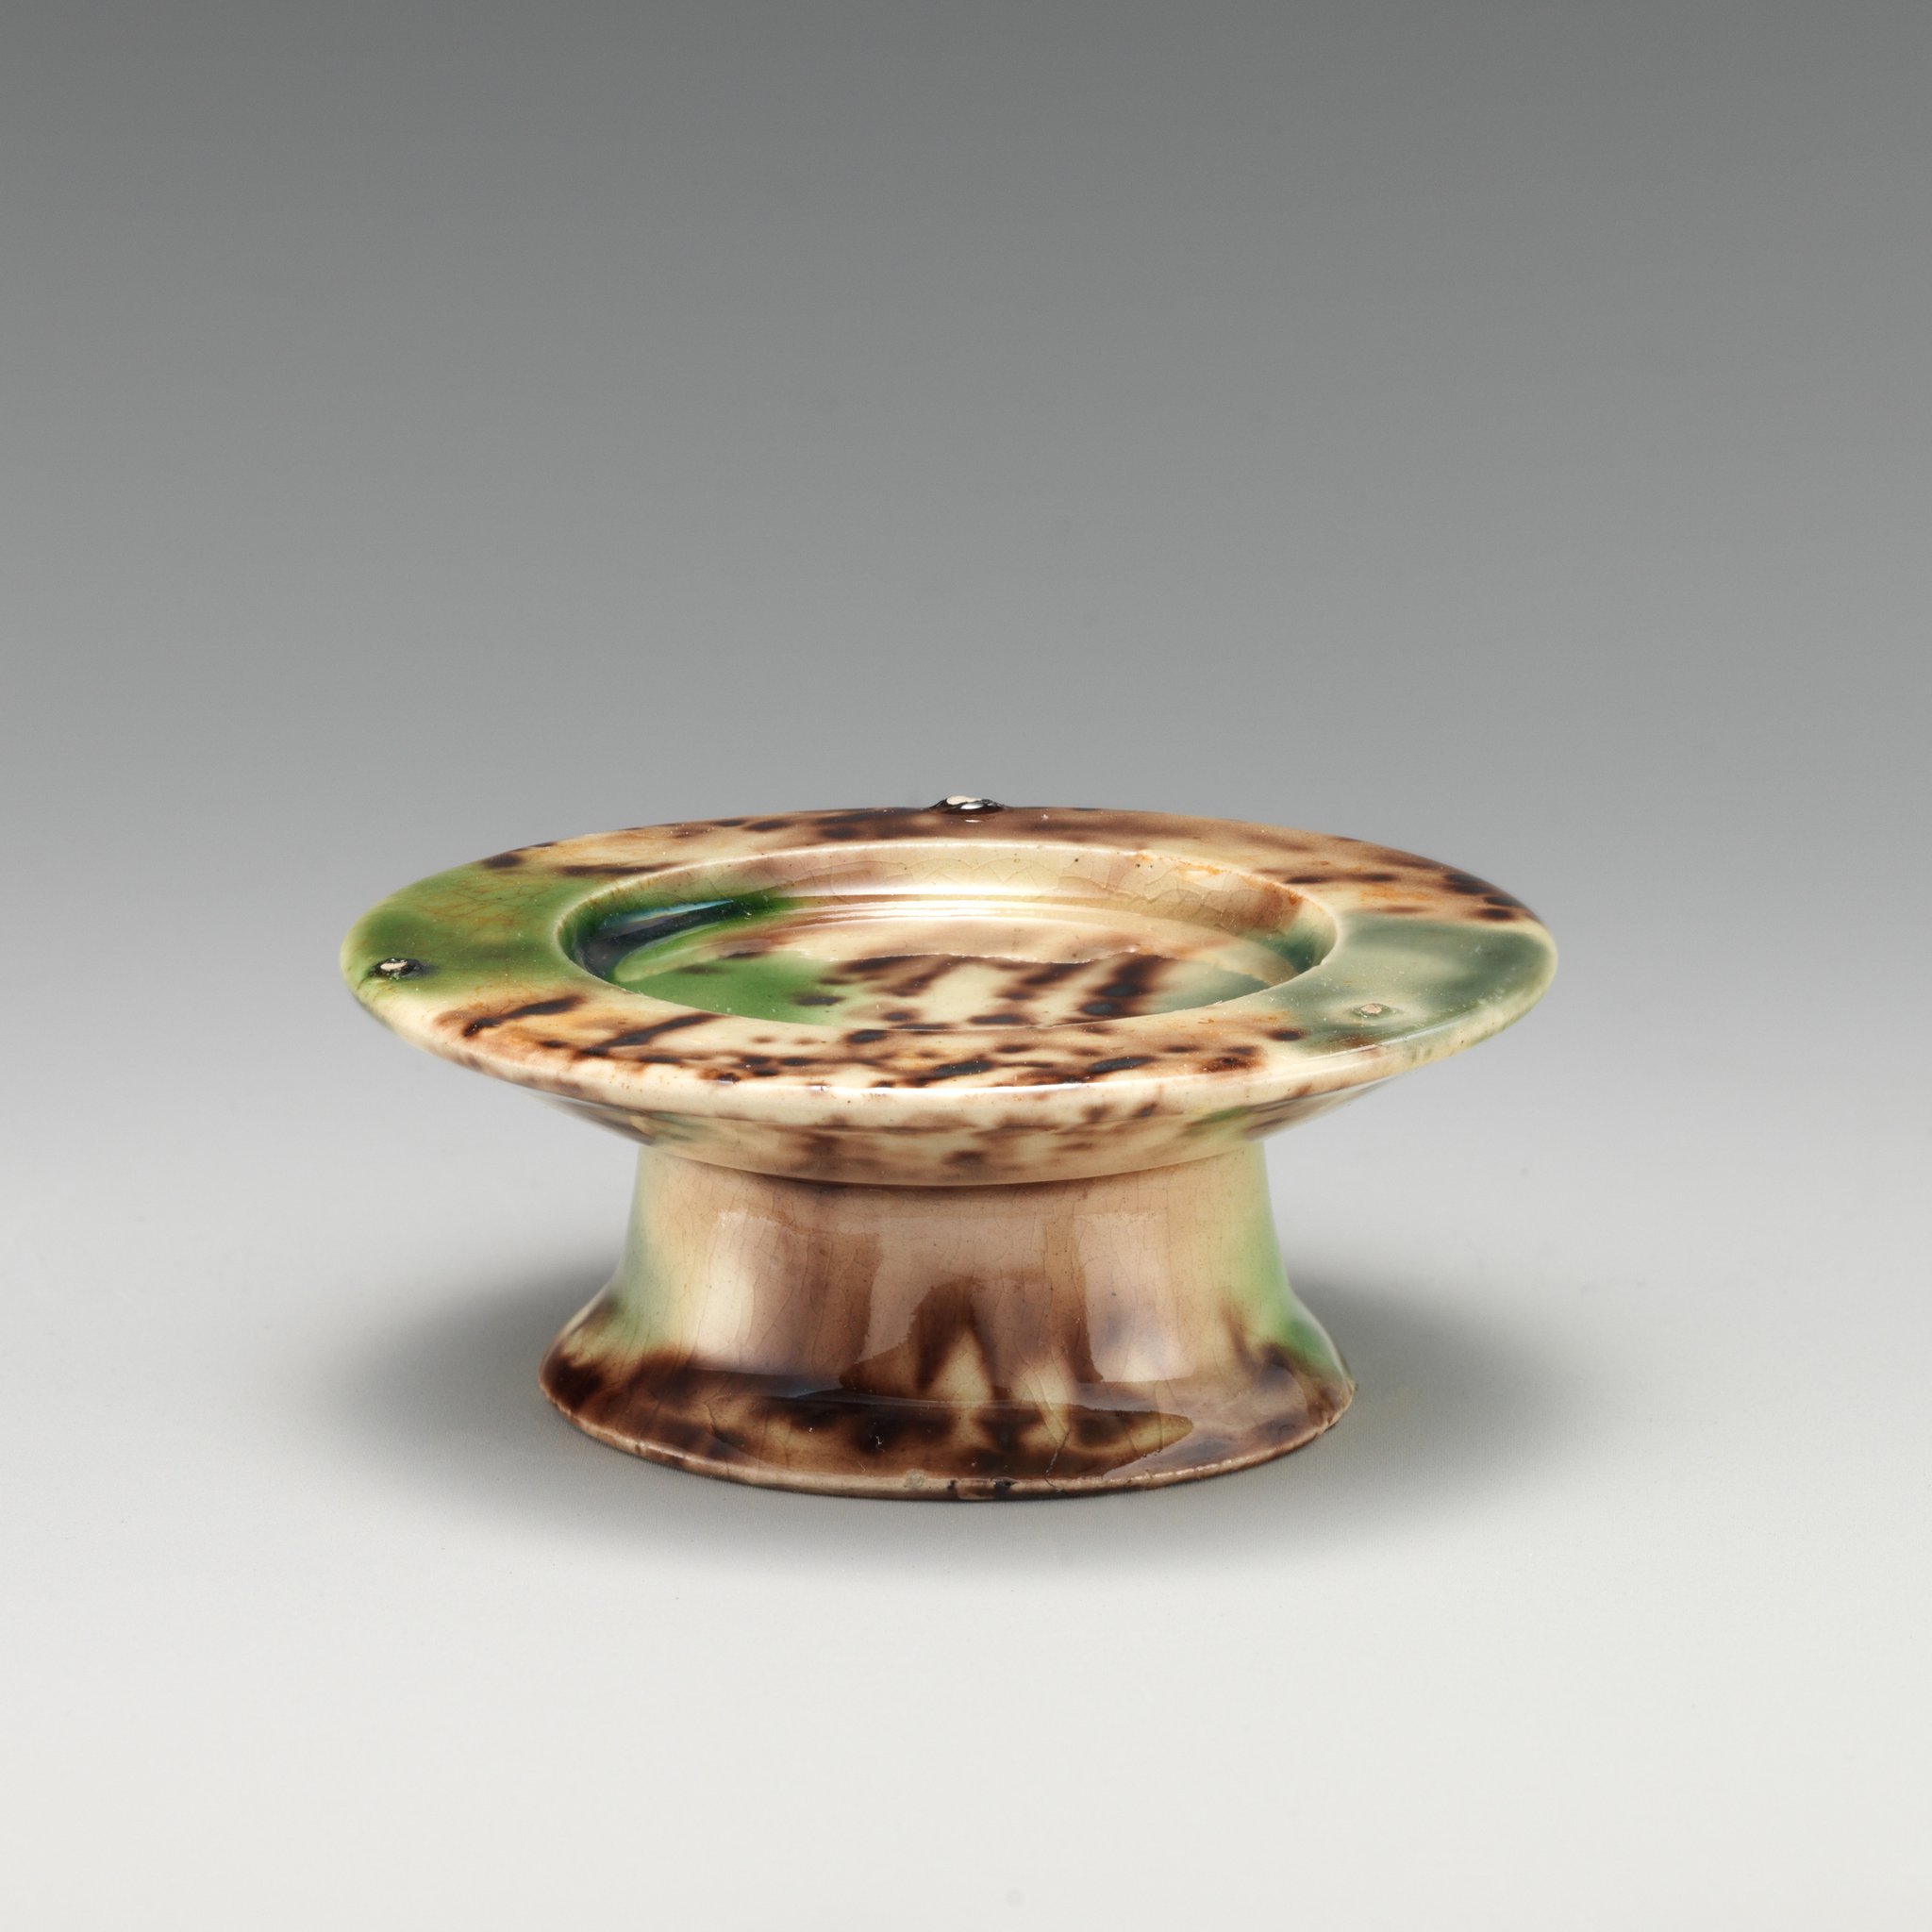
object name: tazza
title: Miniature tazza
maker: whieldon type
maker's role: maker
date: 1751-1775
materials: earthenware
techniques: glazing